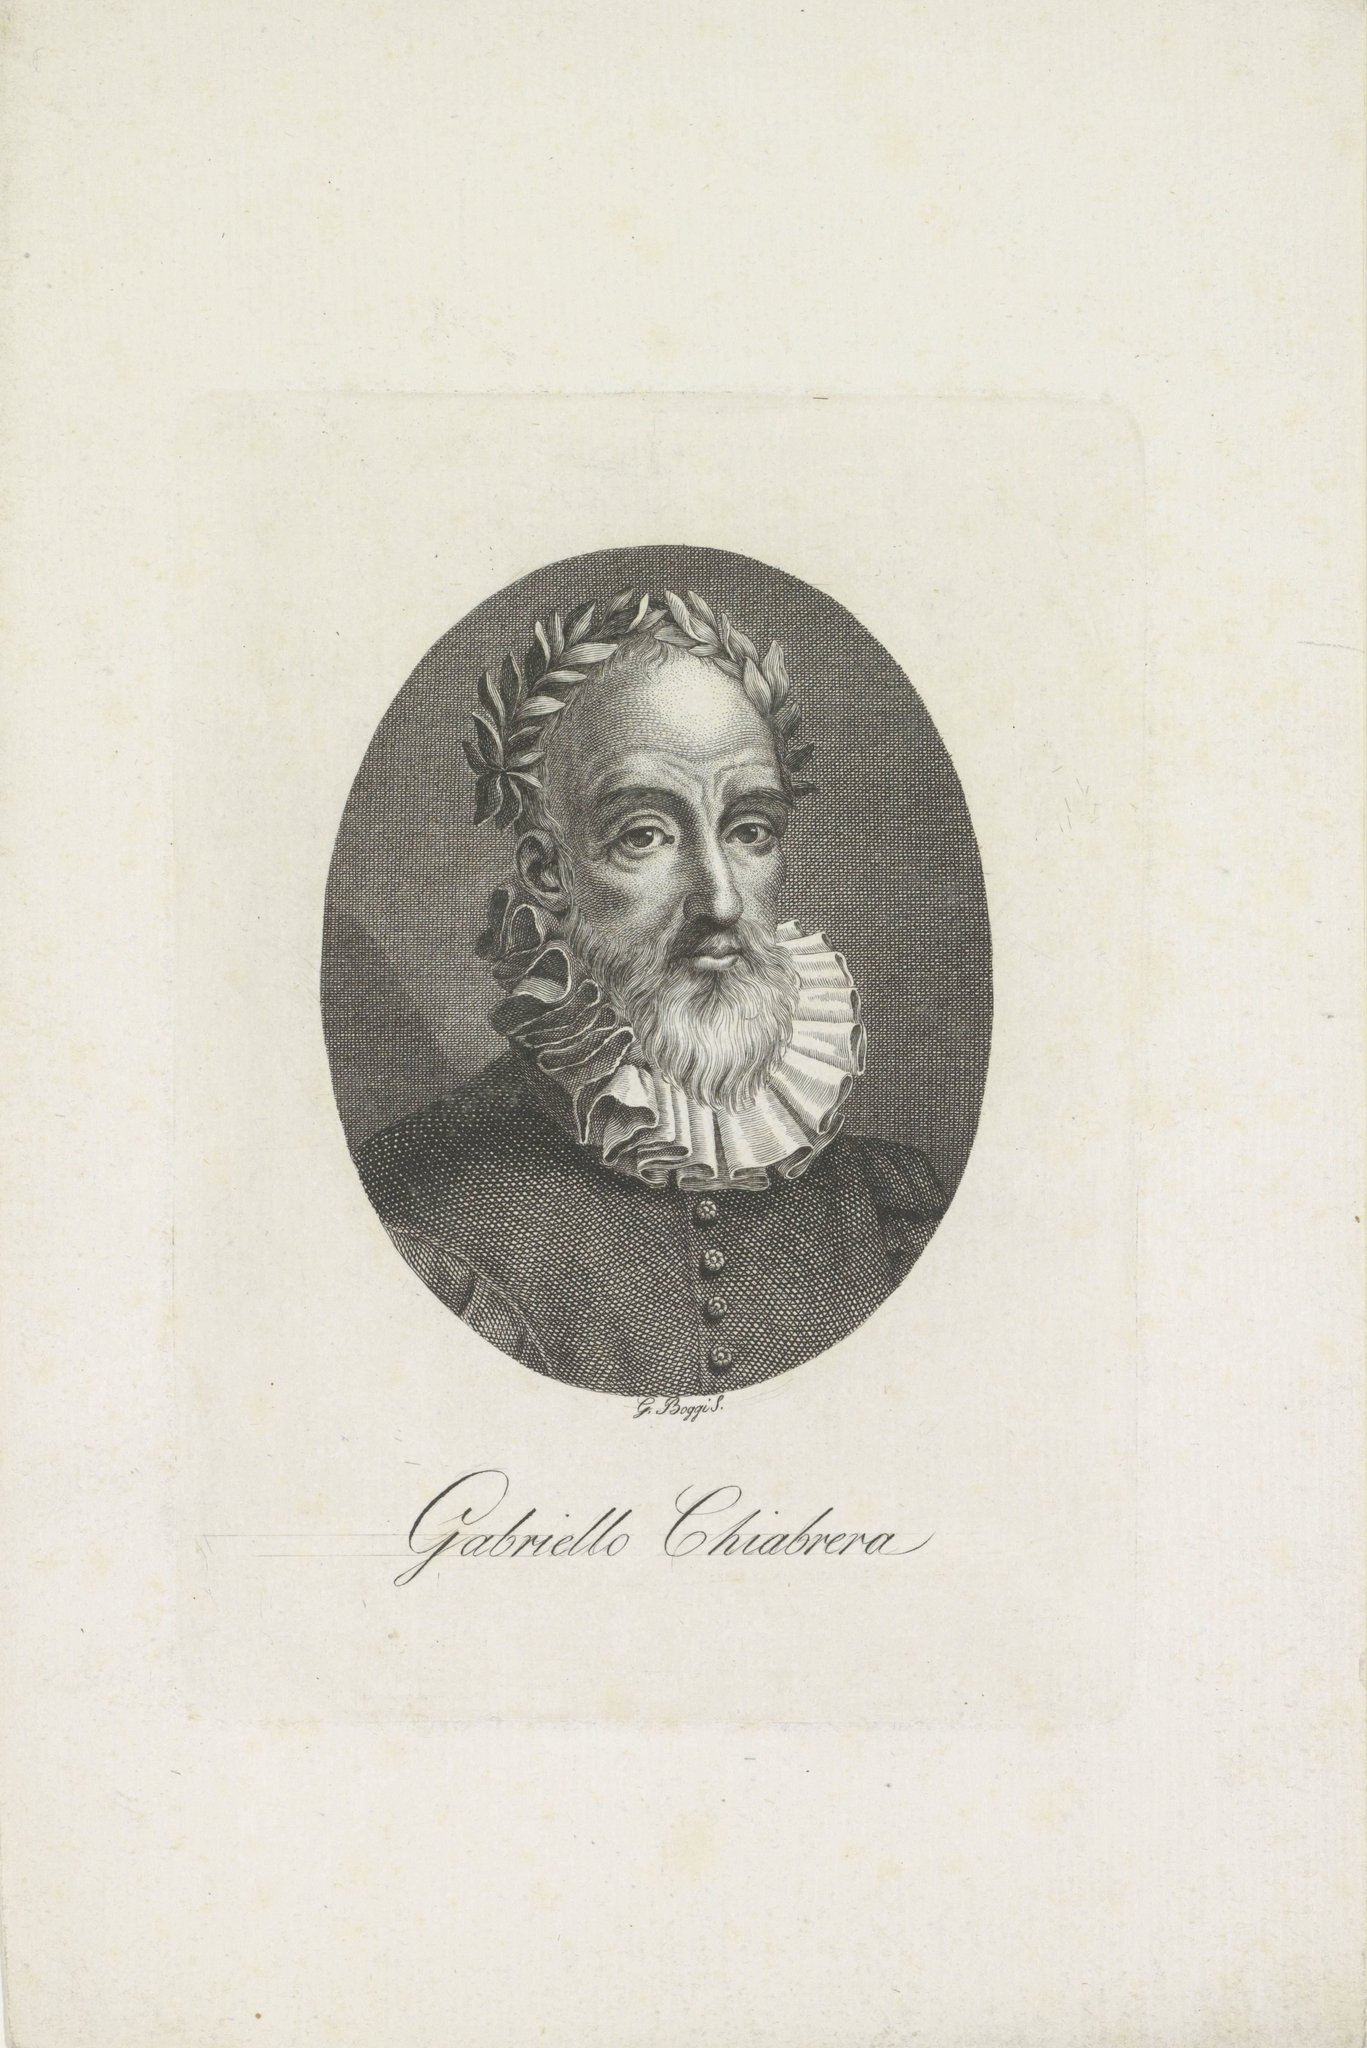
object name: print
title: Portret van dichter Gabriello Chiabrera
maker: giovanni boggi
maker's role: draughtsman, print maker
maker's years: 1770-1832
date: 1780-1832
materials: paper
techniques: engraving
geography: italy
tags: historical persons, portrait of a writer, writer, poet, author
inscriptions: collector's mark: Lugt 2228